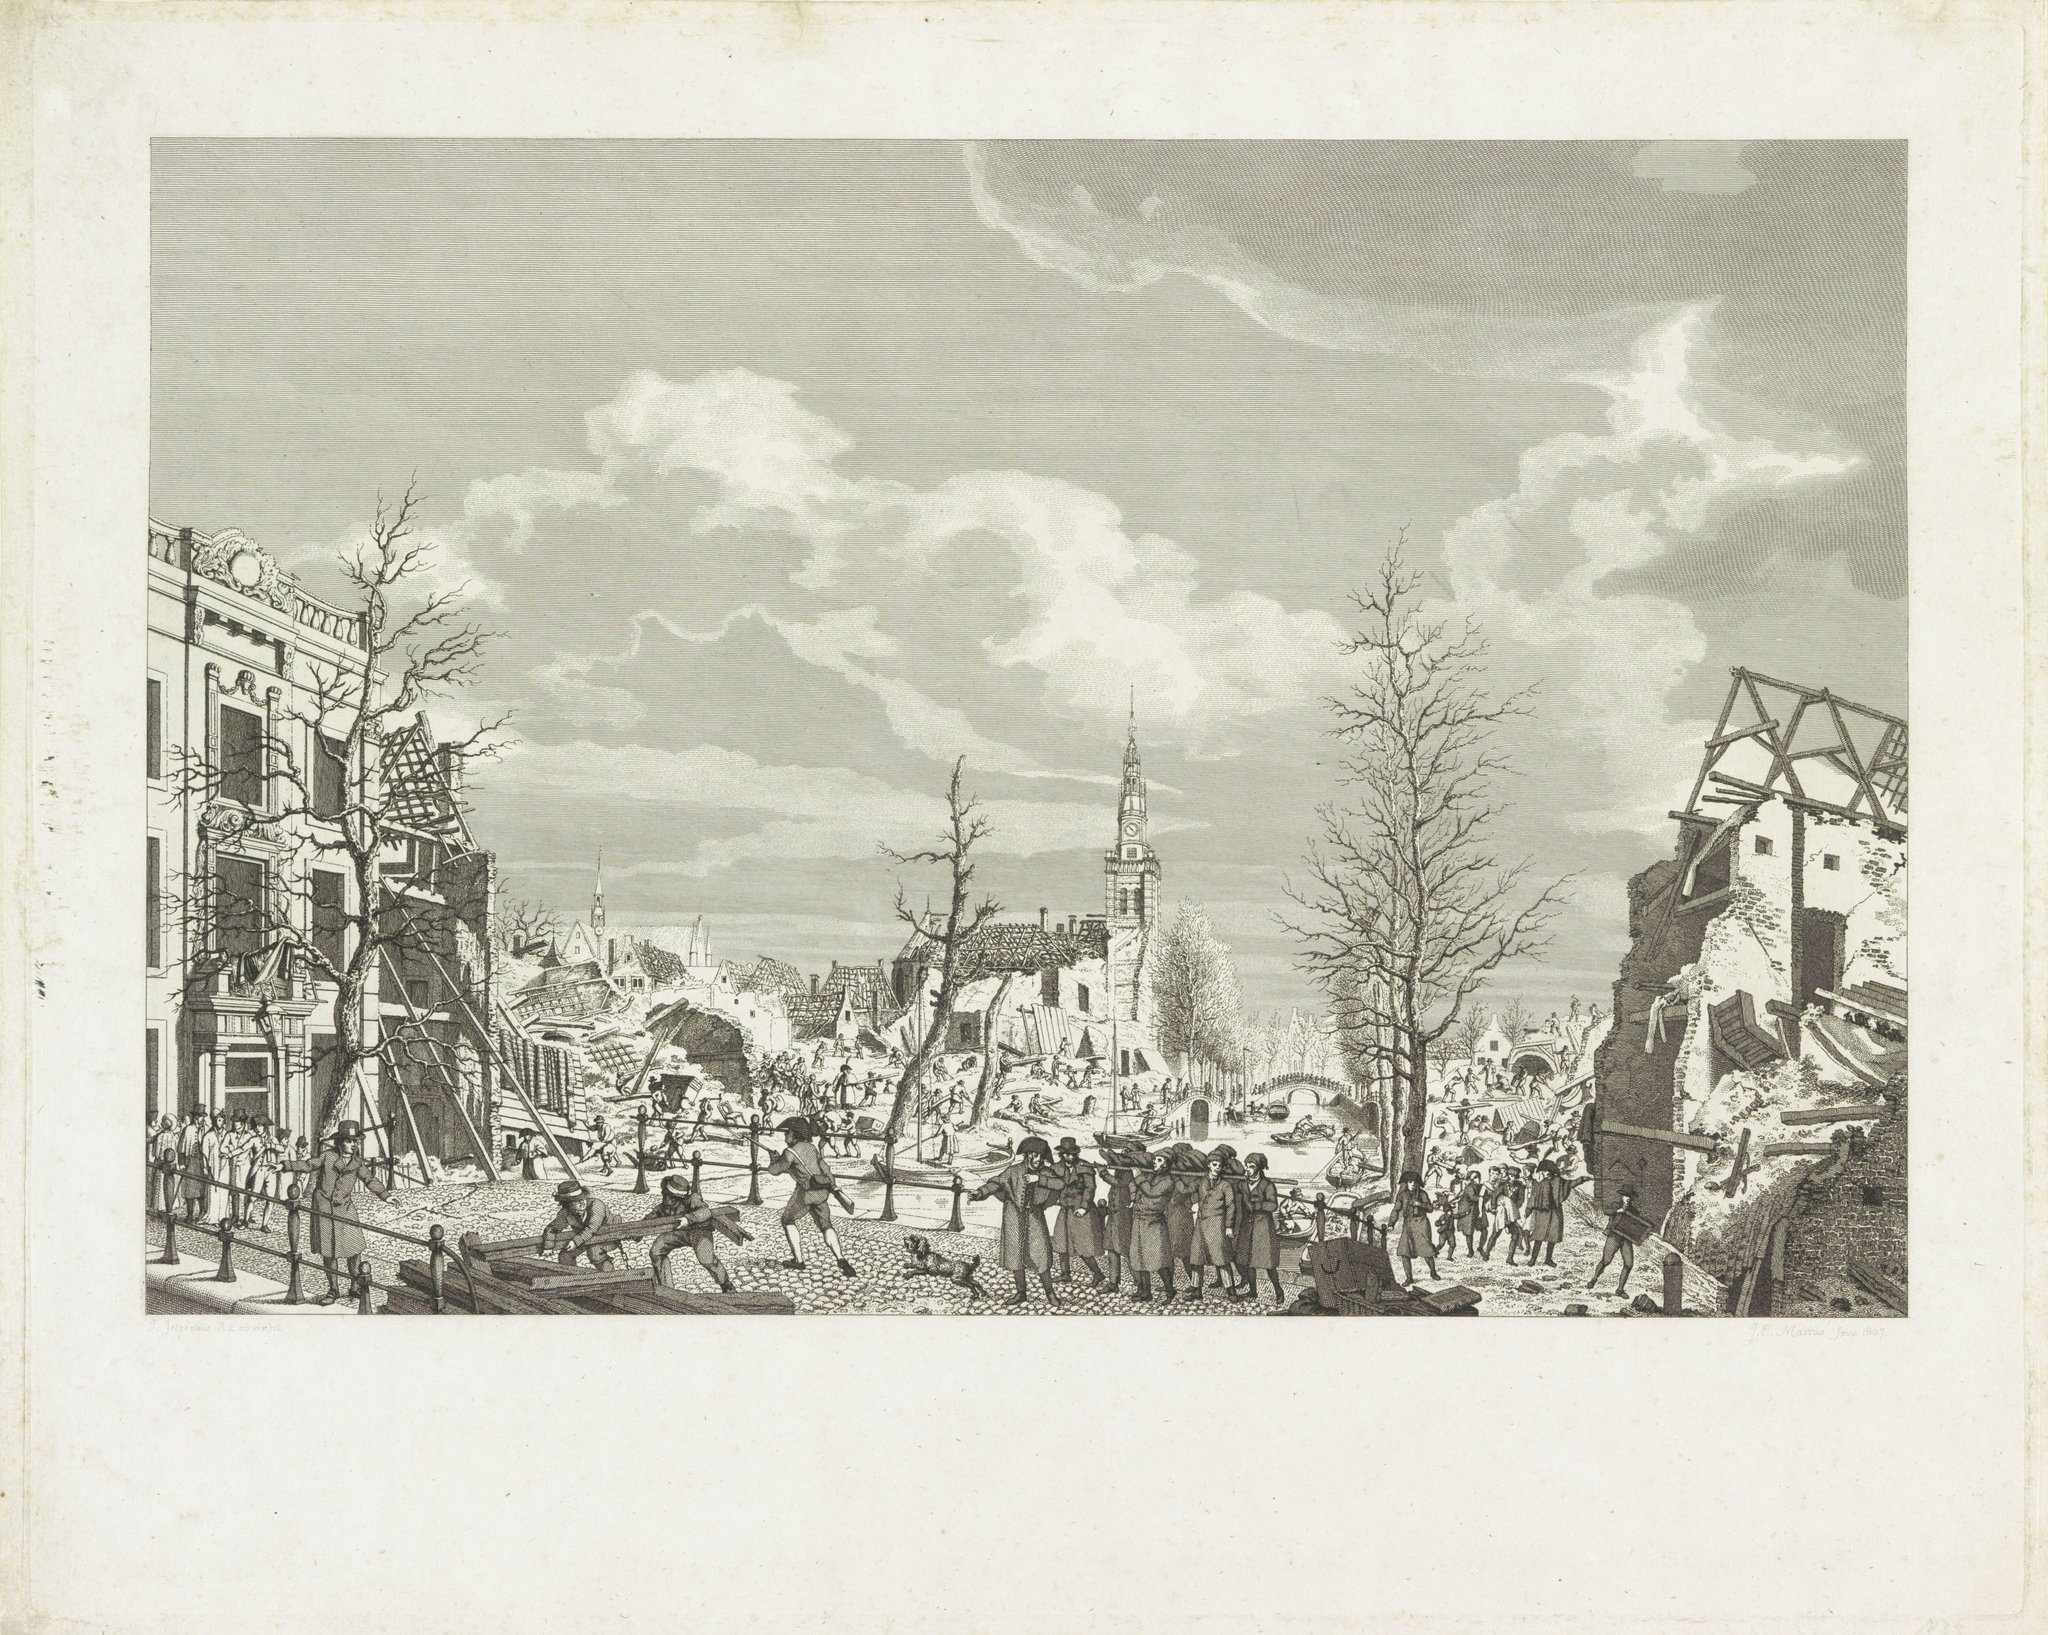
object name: print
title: Ruïnes op het Rapenburg te Leiden na de ramp, 1807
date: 1807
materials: paper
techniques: engraving, etching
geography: netherlands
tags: death caused by undesired effects of human activities, in traffic, at work, etc., gunpowder disaster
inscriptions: collector's mark: Lugt 2228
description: Gezicht vanaf de Nieuwsteegbrug op het verwoest gebied na de buskruitramp op het Steenschuur, een gracht in het verlengde van het Rapenburg, te Leiden op 12 januari 1807. Opruimwerkzaamheden na de ramp, centraal de Saaihal, links in de verte de Pieterskerk. Op de voorgrond wordt het lichaam van een slachtoffer weggedragen.